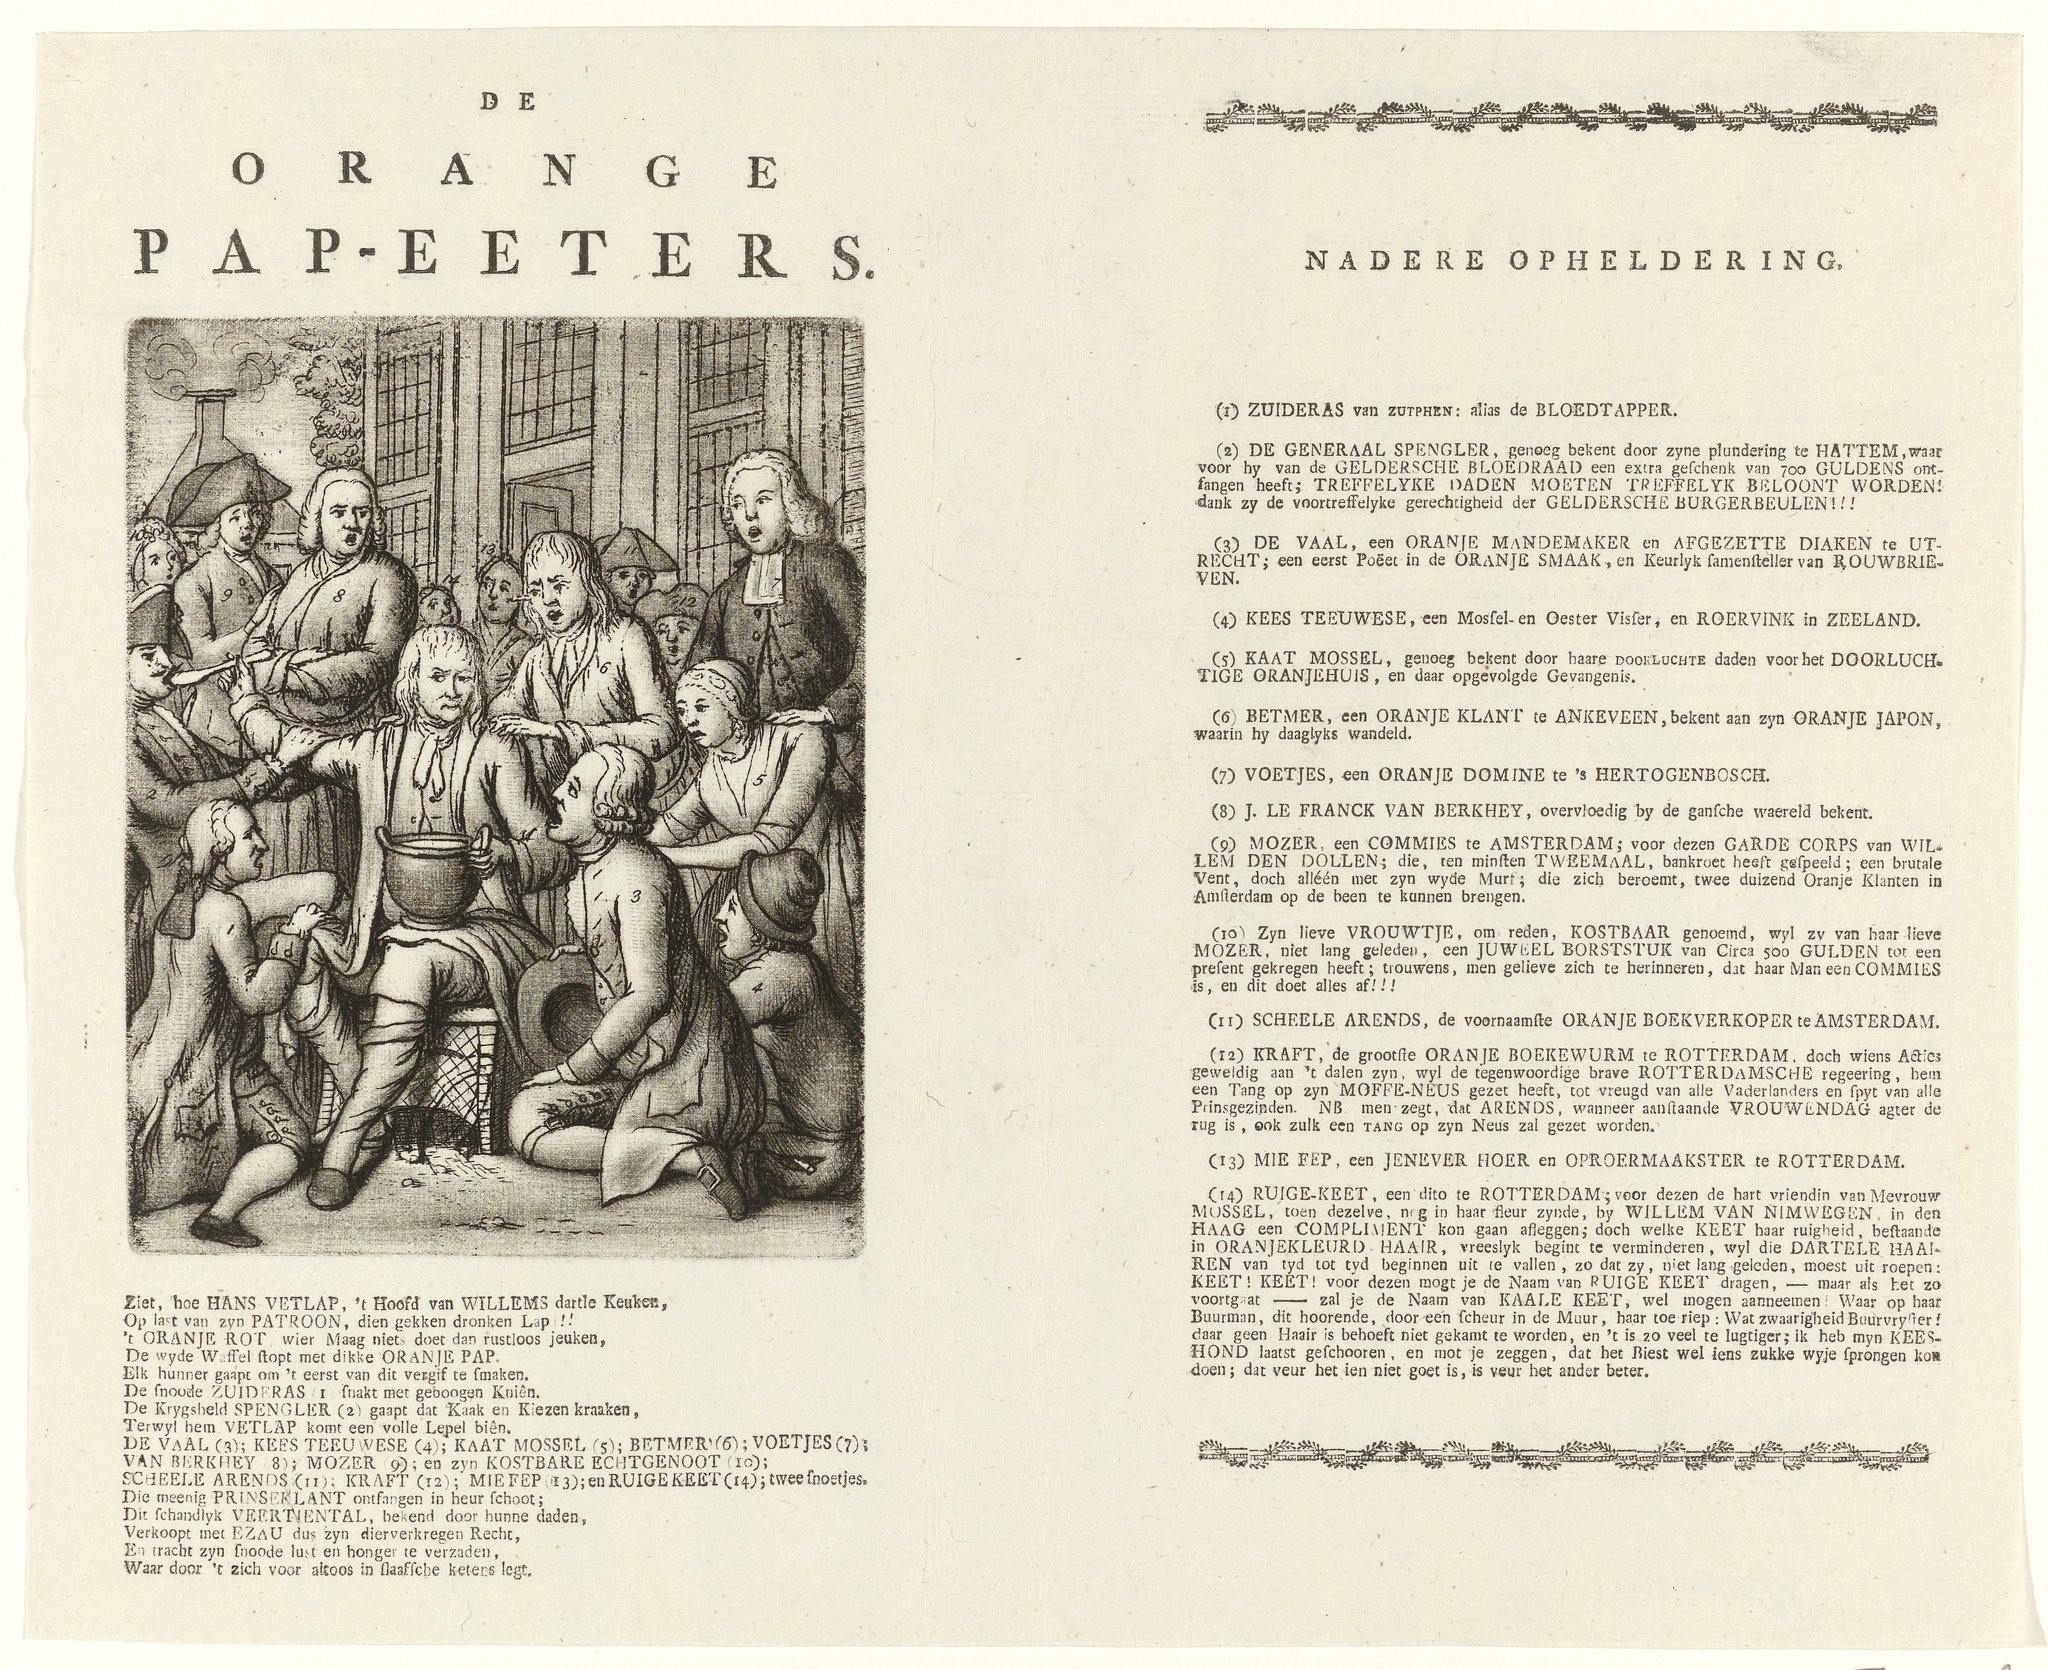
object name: print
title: De Orange Pap-eeters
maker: rienk jelgerhuis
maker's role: draughtsman, print maker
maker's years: 1729-1806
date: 1786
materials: paper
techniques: letterpress printing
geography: northern netherlands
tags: leiden, print maker, draughtsman, johannes le francq van berkhey, rotterdam, kaat mossel, giving food, cereal (+ taking (particular) foodstuffs: eating, drinking, smoking, chewing, etc.), patriots (1780-1795)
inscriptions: collector's mark: Lugt 2228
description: Spotprent op de orangisten na de gebeurtenissen rond Hattem en Elburg, begin september 1786. Een Orangist voert met een lepel oranjepap aan een grote schare van Oranjeklanten. Tot de groep behoren generaal Spengler, Kaat Mossel, Betmer van Ankeveen, dominee Voetjes van Den Bosch, Johannes Le Francq van Berkhey, (Schele) Arends, boekverkoper te Amsterdam, Kraft, boekverkoper te Rotterdam en anderen. Op het blad onder de plaat een zestienregelig vers, op de tegenoverliggende bladzijde een legenda 1-14 op de voorstelling.